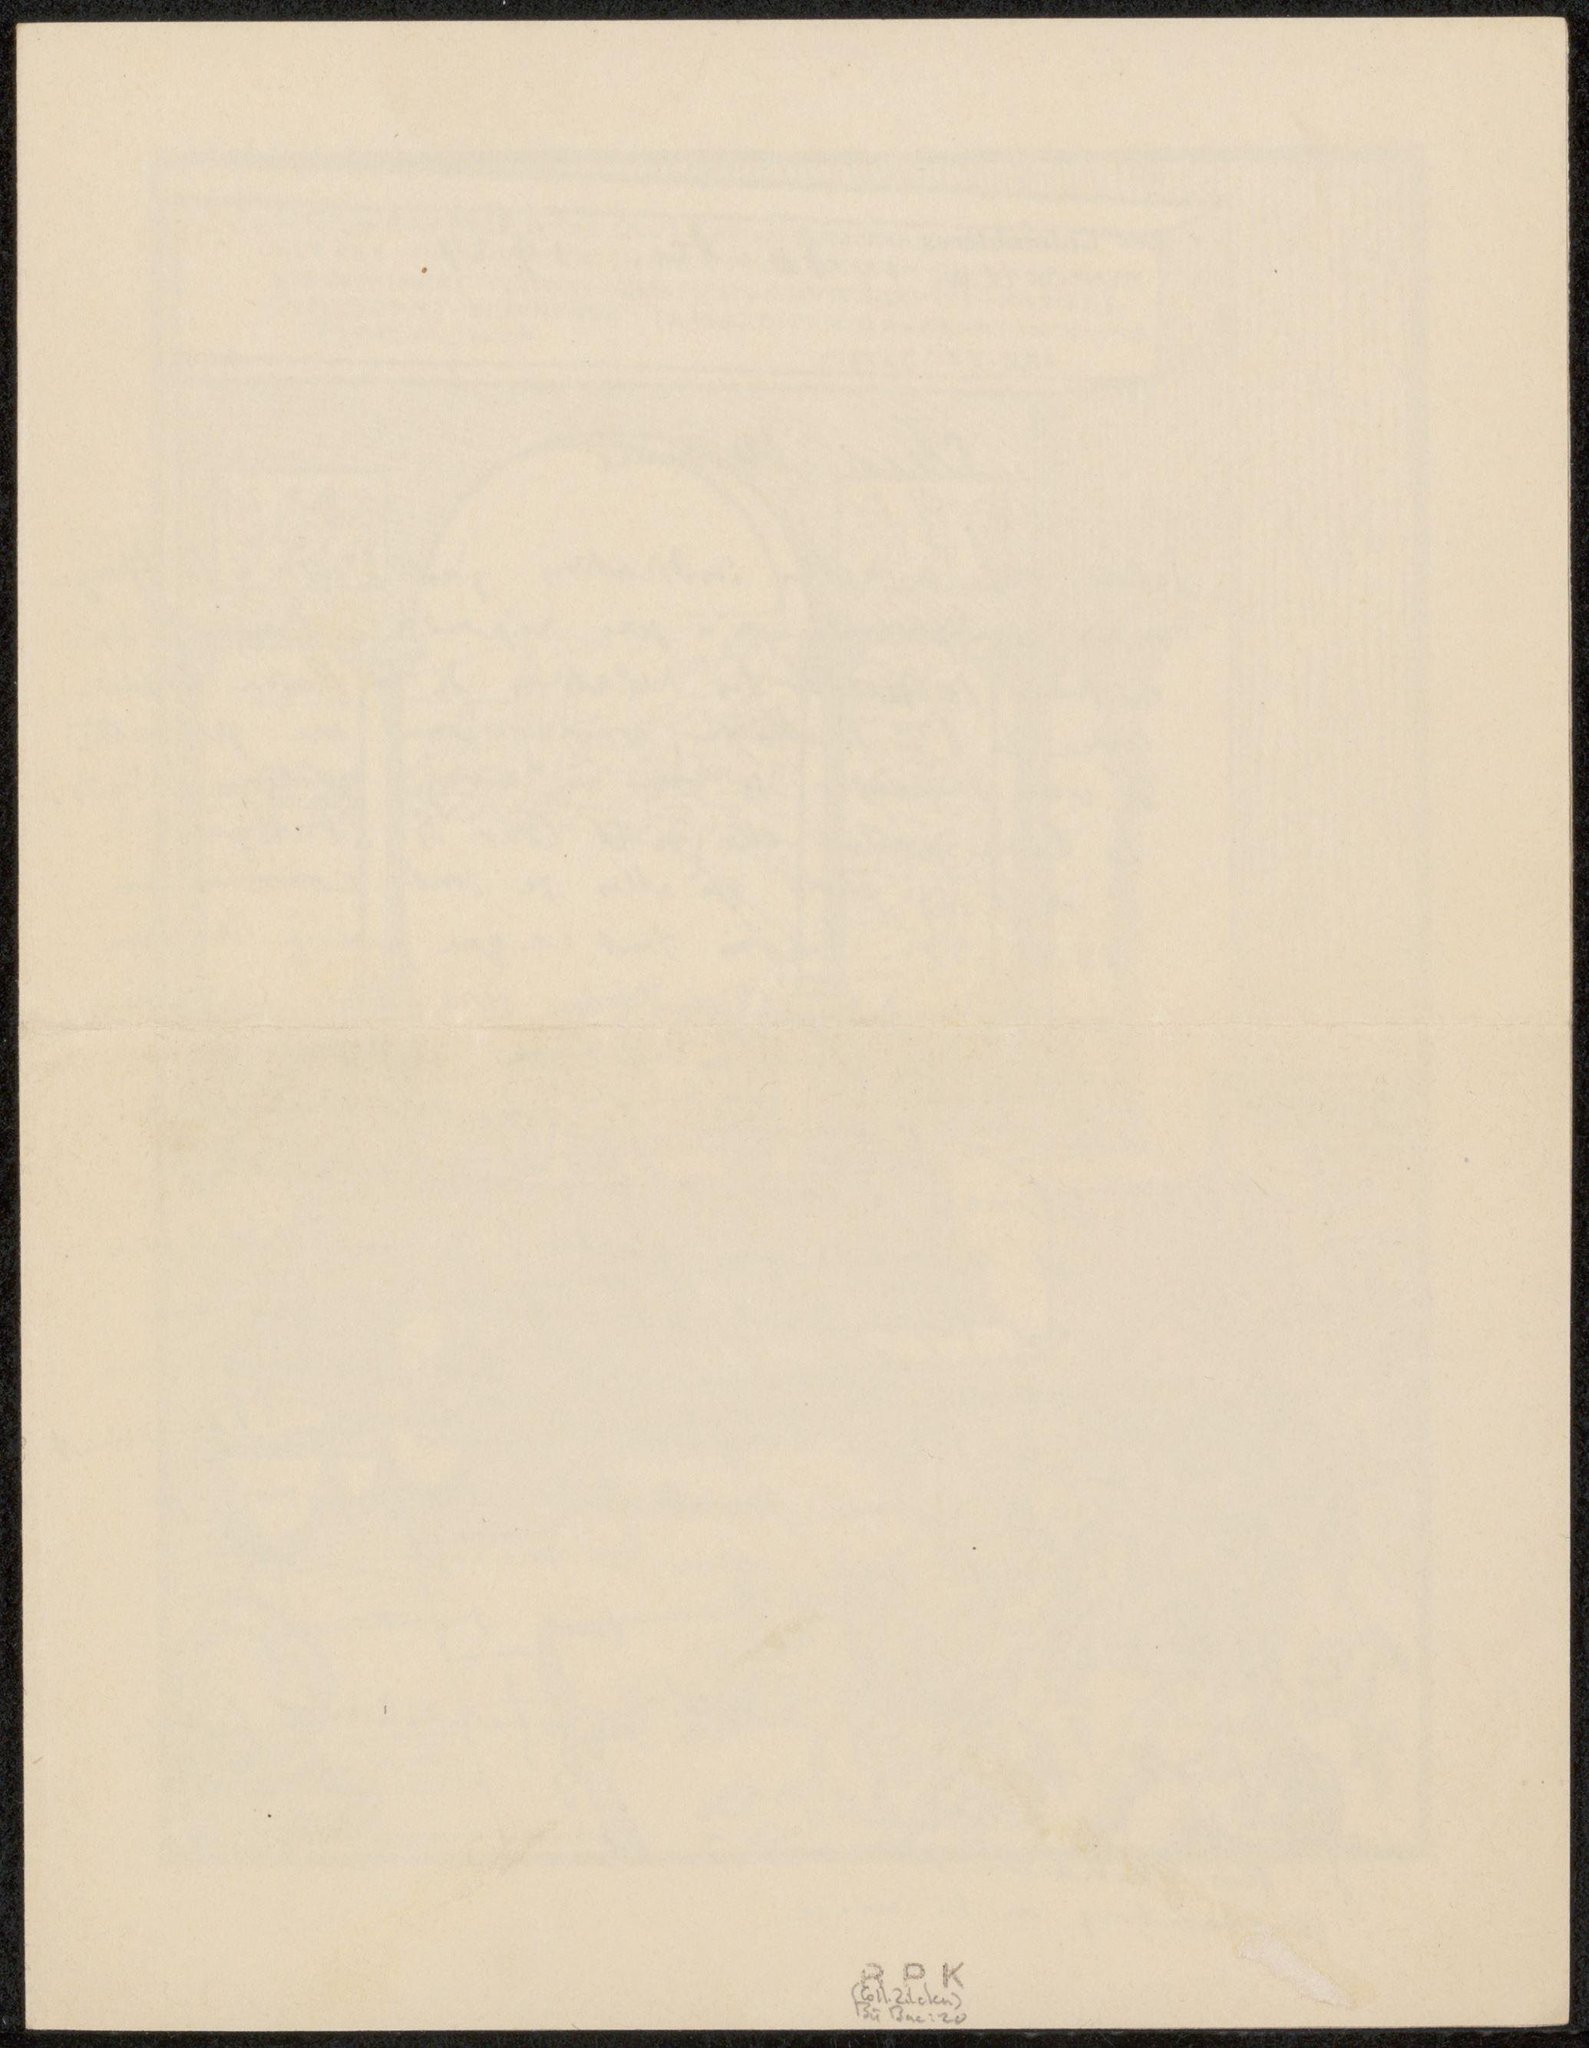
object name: letter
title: Brief aan Philip Zilcken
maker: ferdinand-sigismund bac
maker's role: draughtsman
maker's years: 1859-1952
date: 1927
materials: ink, paper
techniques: pen, printing, writing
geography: menton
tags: the hague, painter, draughtsman, philip zilcken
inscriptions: collector's mark: ‘RPK’